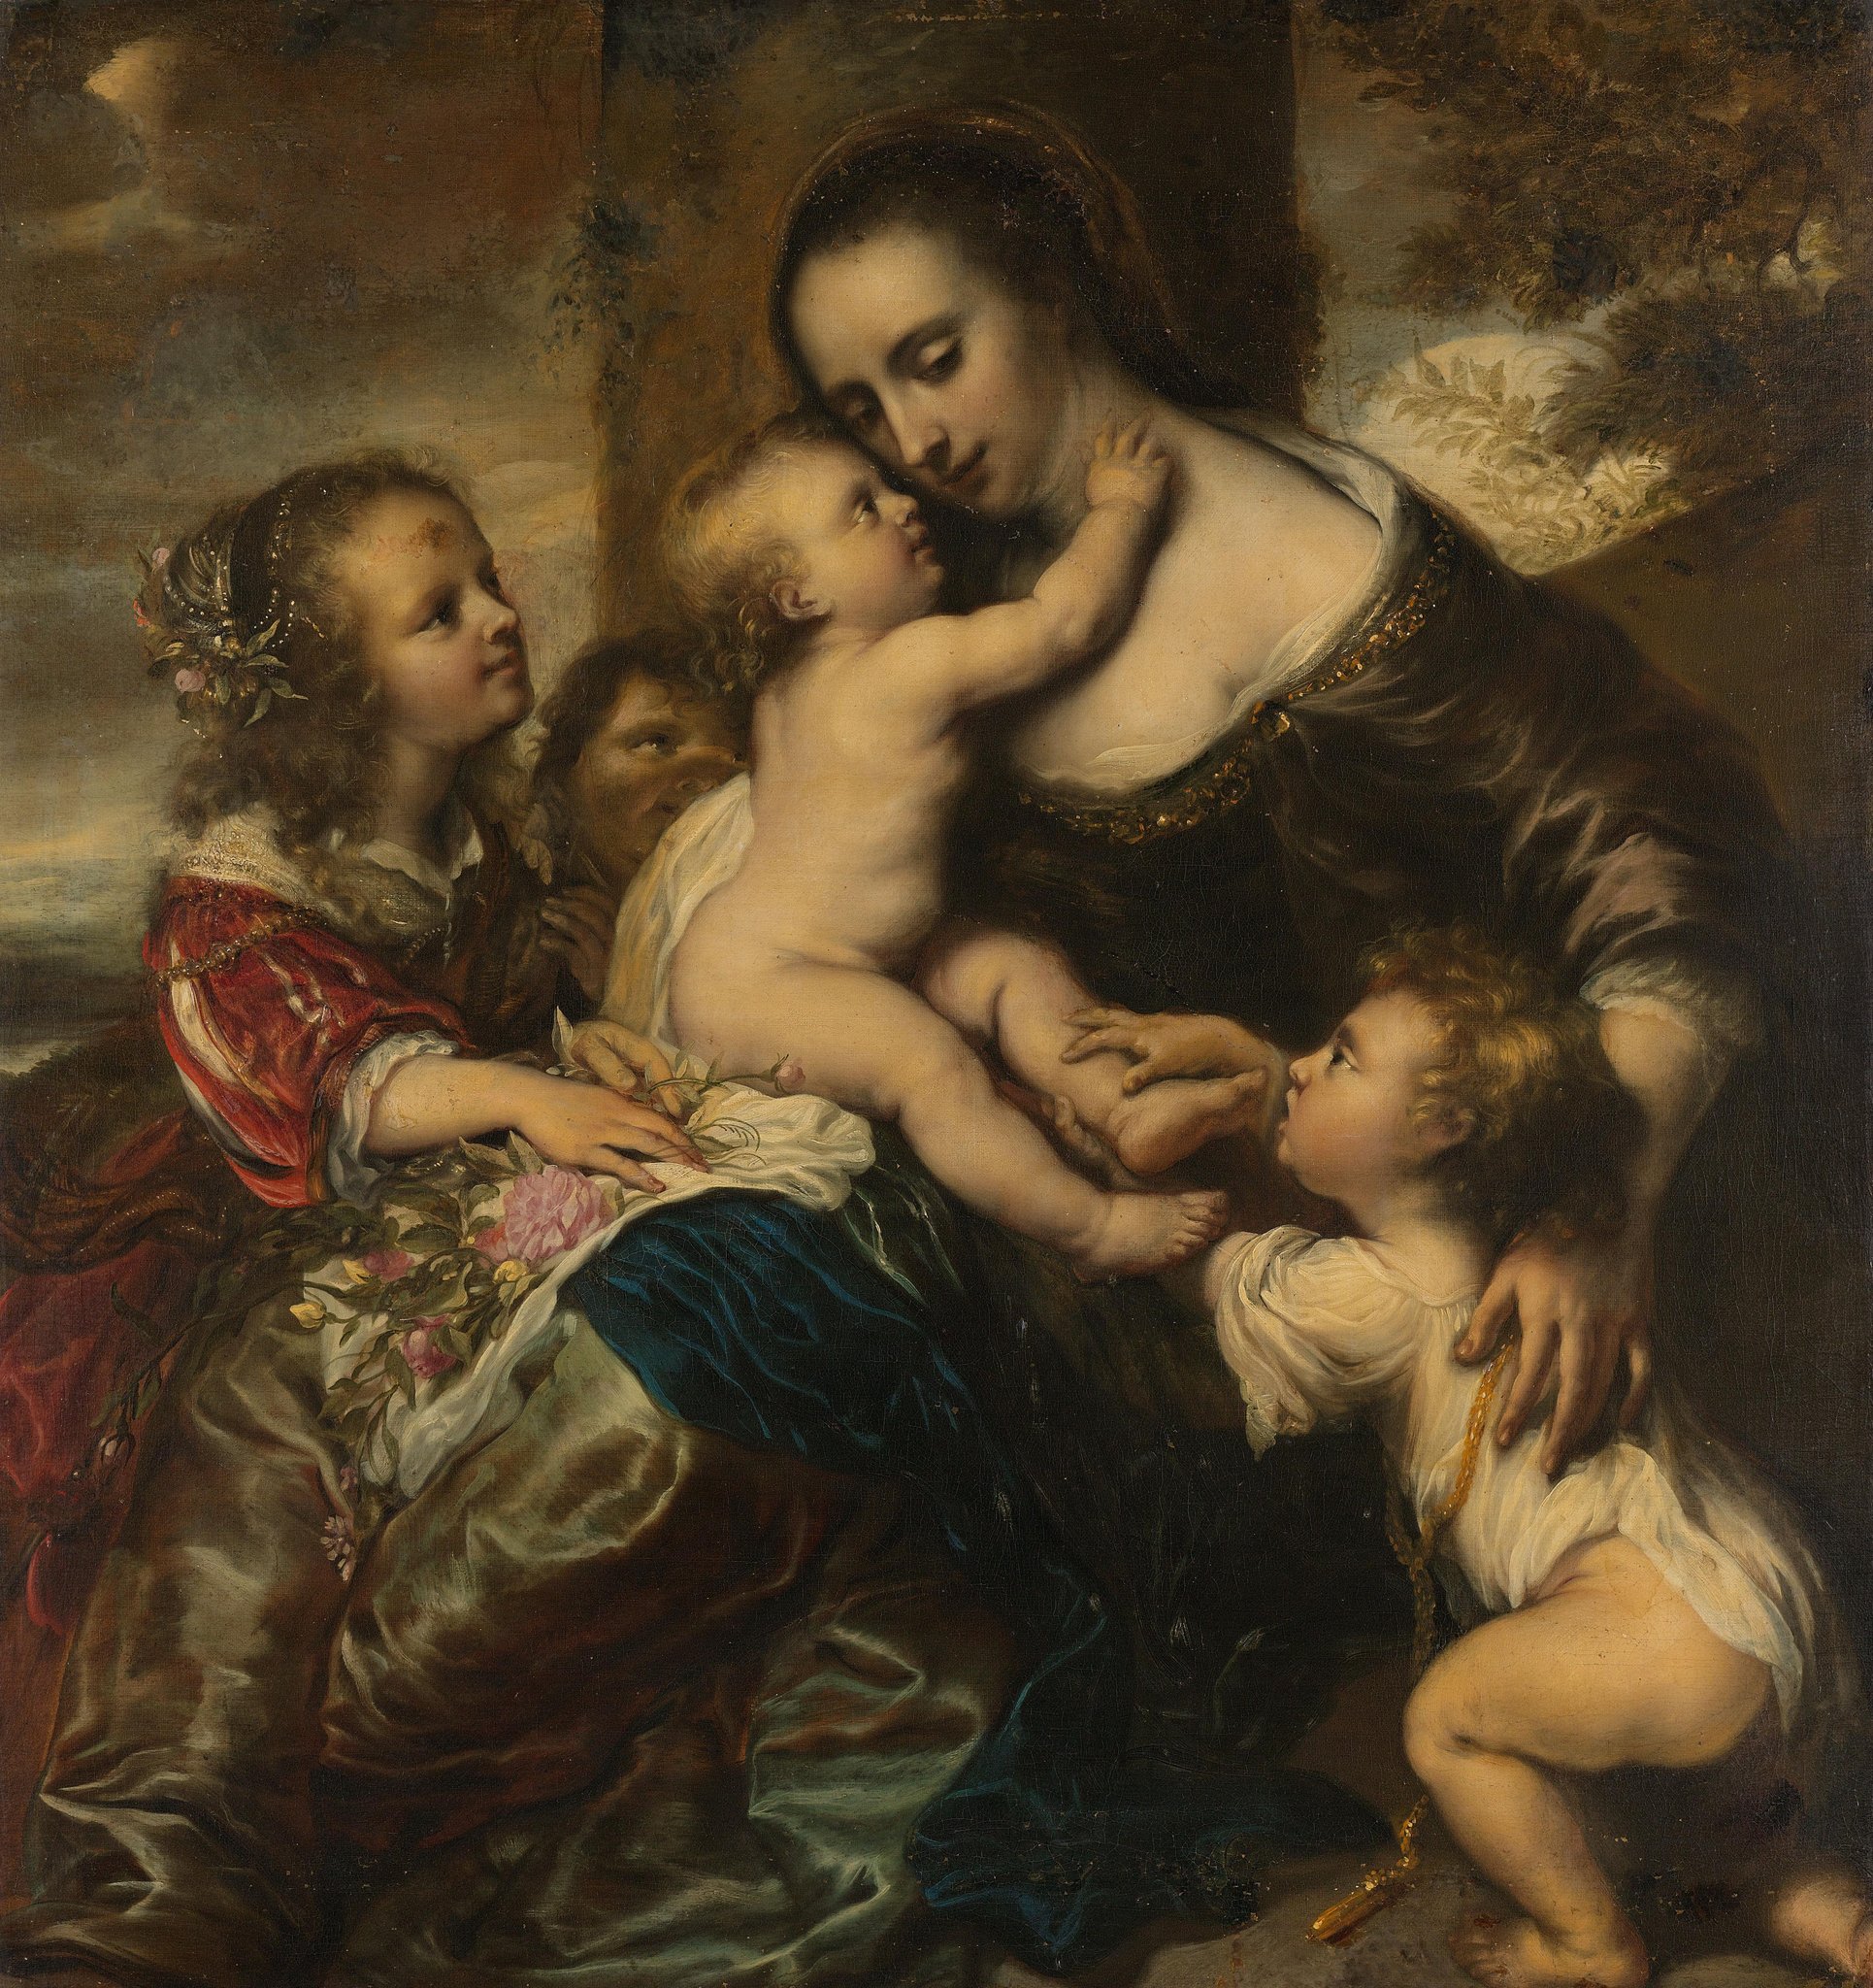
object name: painting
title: Portrait of a woman with four children, depicted as Caritas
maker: jürgen ovens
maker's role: draughtsman, painter, print maker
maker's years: 1623-1678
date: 1650-1678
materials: canvas, oil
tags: charity, 'caritas'; 'carità' (ripa) ~ one of the three theological virtues, historical persons not known by name - bb - woman, mother and baby or young child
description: Portret van een vrouw met vier kinderen, voorgesteld als Caritas, de Liefde. Zittend aan de voet van een boom, een naakt kind op schoot, rechts een meisje met een bloemen.